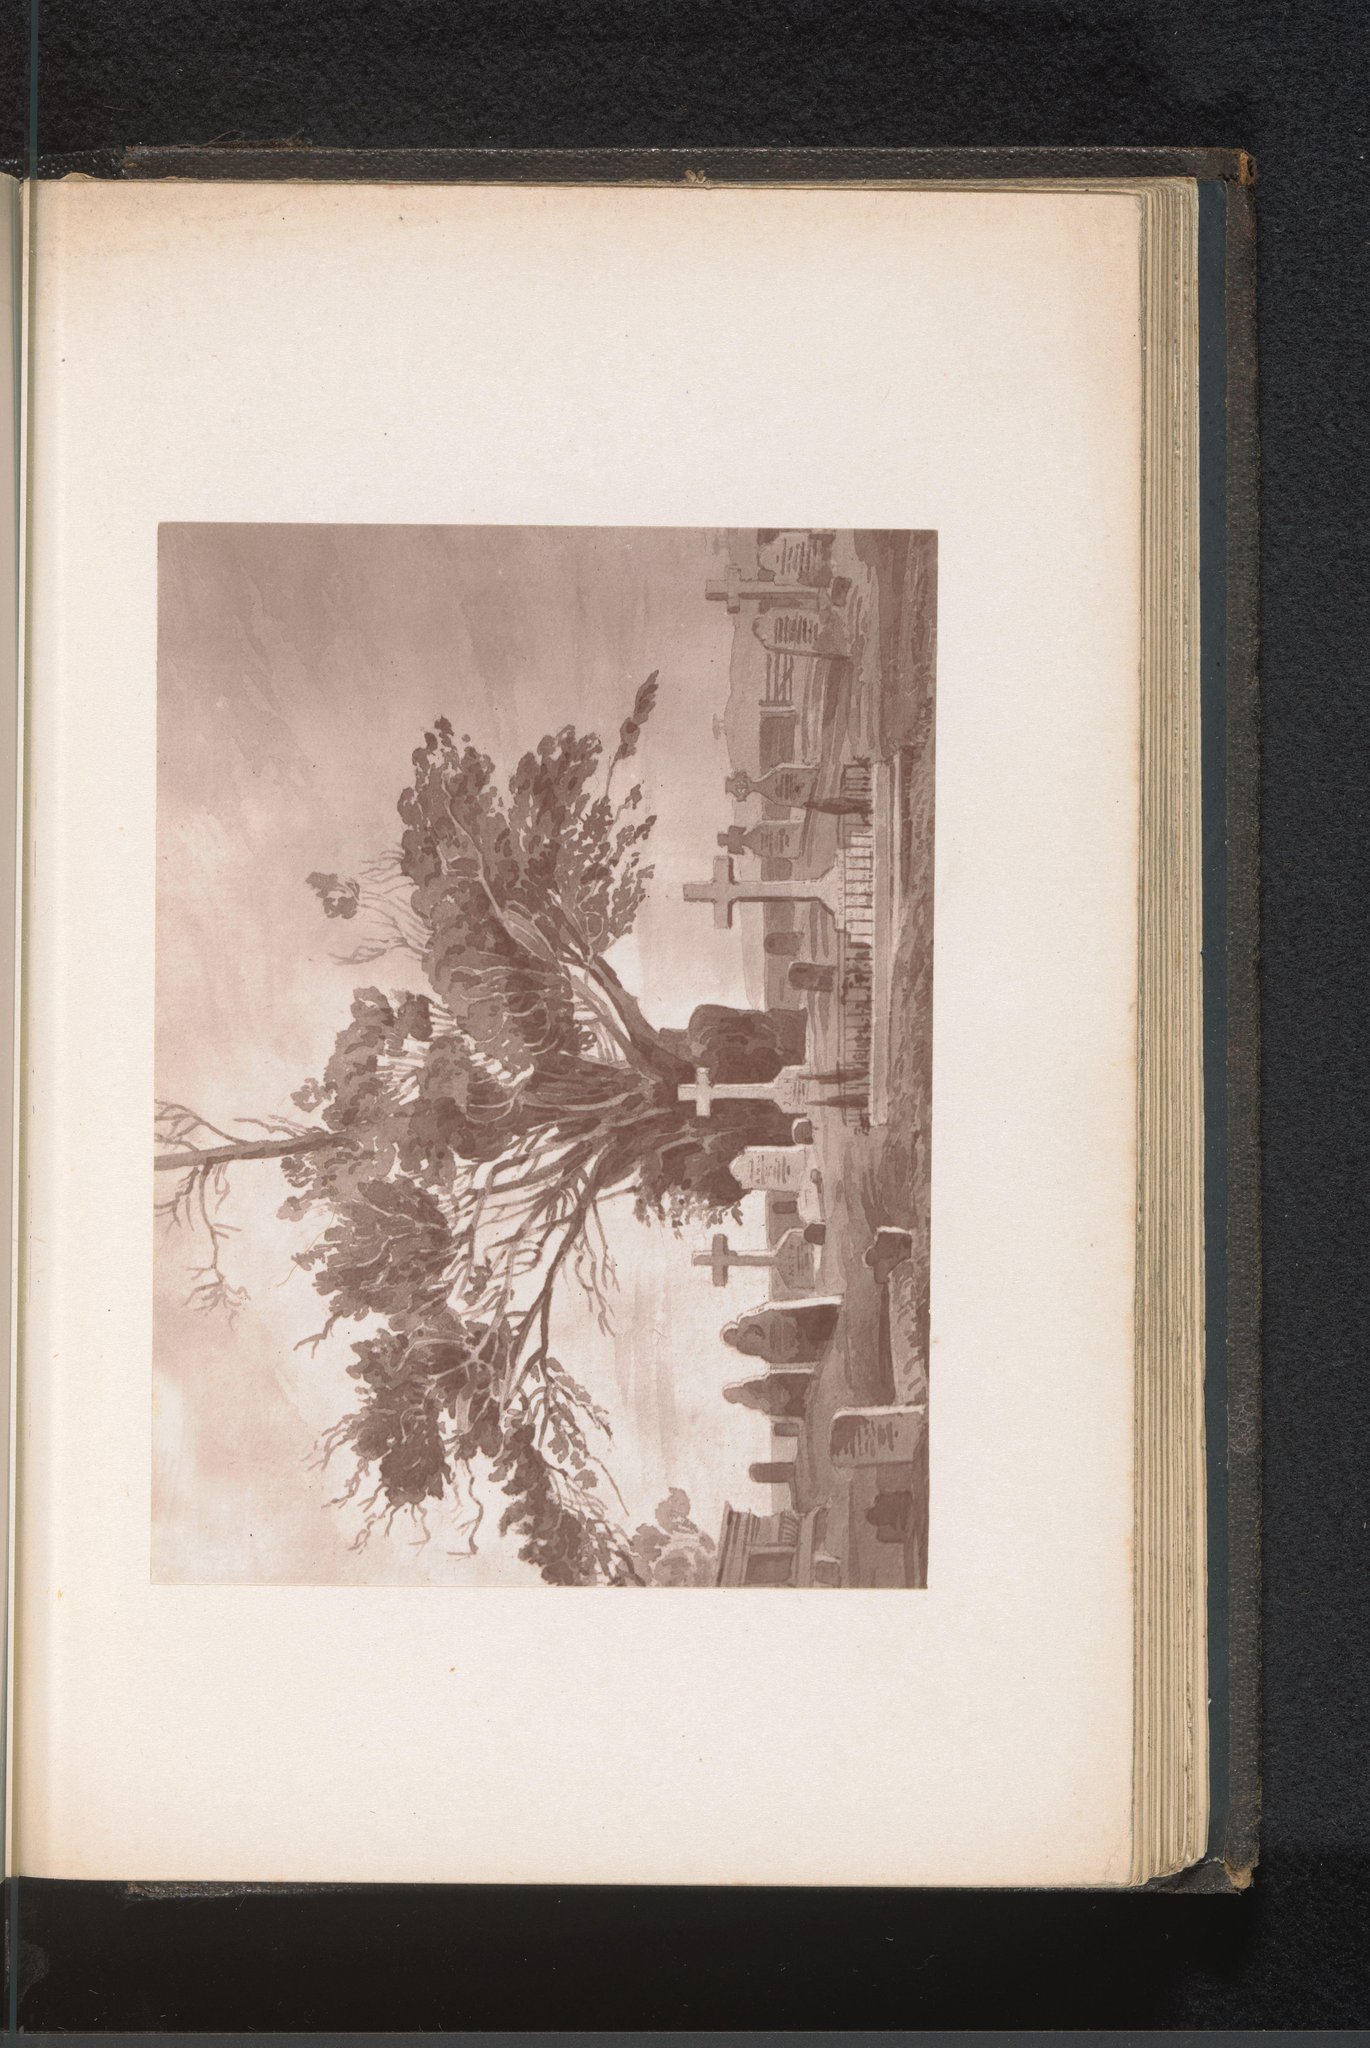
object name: photomechanical print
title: Fotoreproductie van een tekening, voorstellende de begraafplaats van Herstmonceux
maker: Anonymous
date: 1866-1876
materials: paper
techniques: woodburytype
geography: herstmonceux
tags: churchyard, cemetery